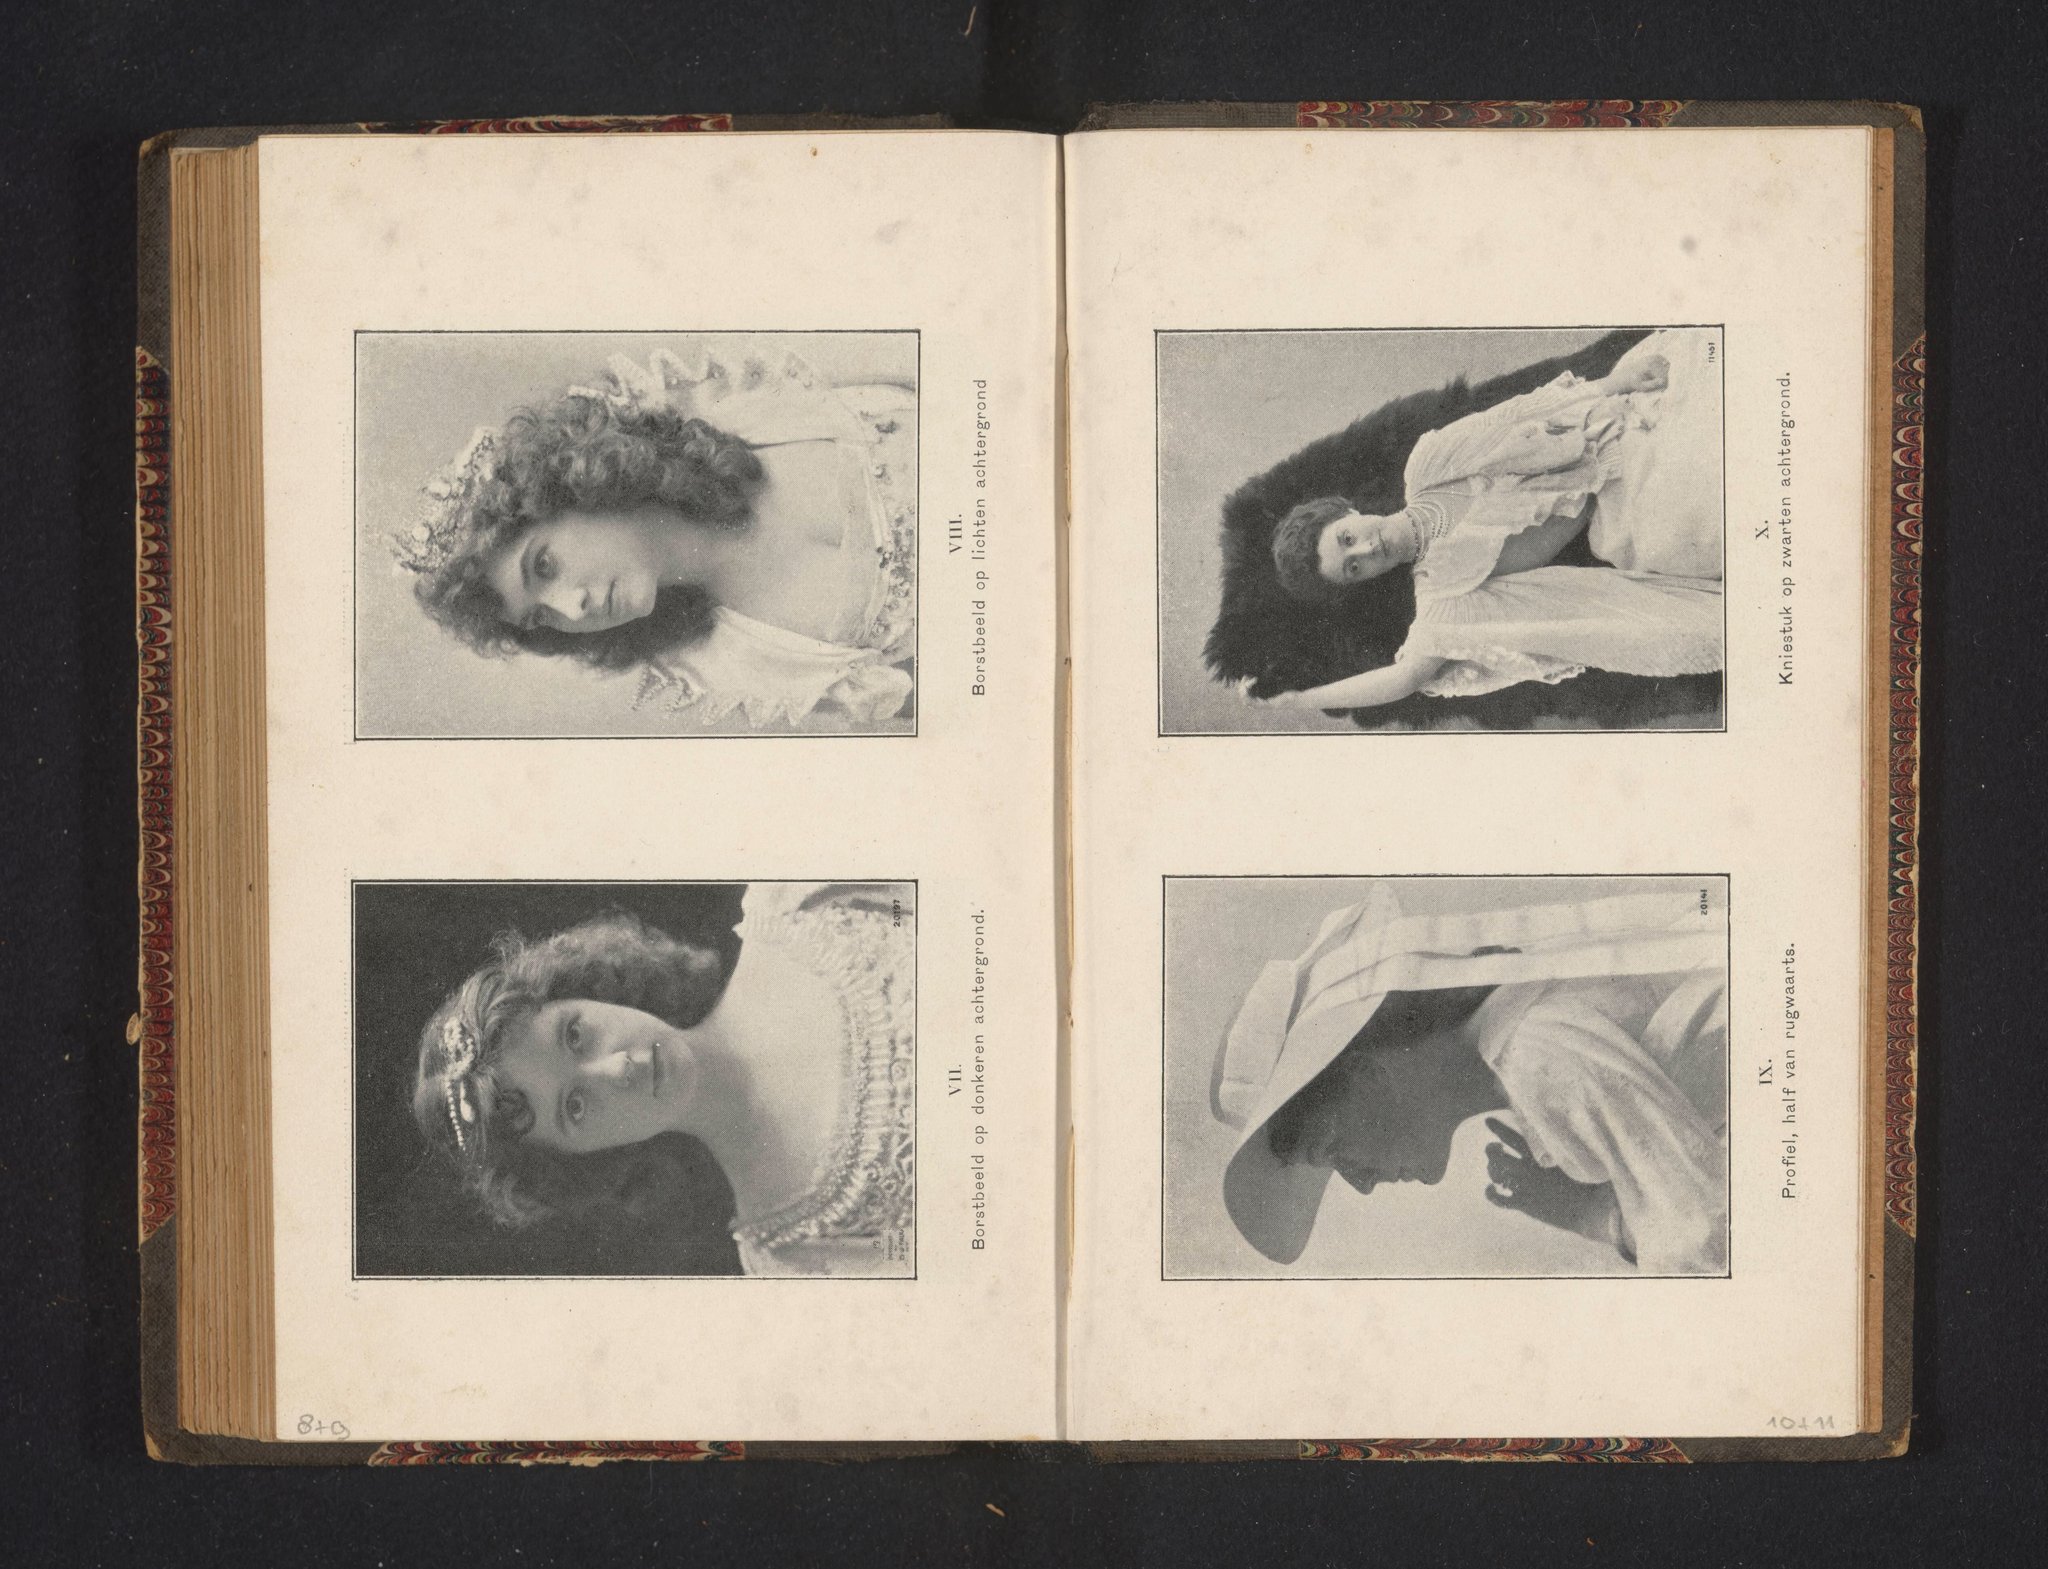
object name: photomechanical print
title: VII./ Borstbeeld op donkeren achtergrond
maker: Anonymous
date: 1897-1902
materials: paper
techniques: autotype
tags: historical persons not known by name - bb - woman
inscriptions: number: ‘20197’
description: Prent zeven van veertien prenten na pagina 241.